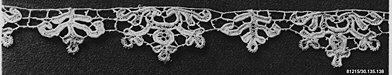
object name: edging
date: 1601-1700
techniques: lace